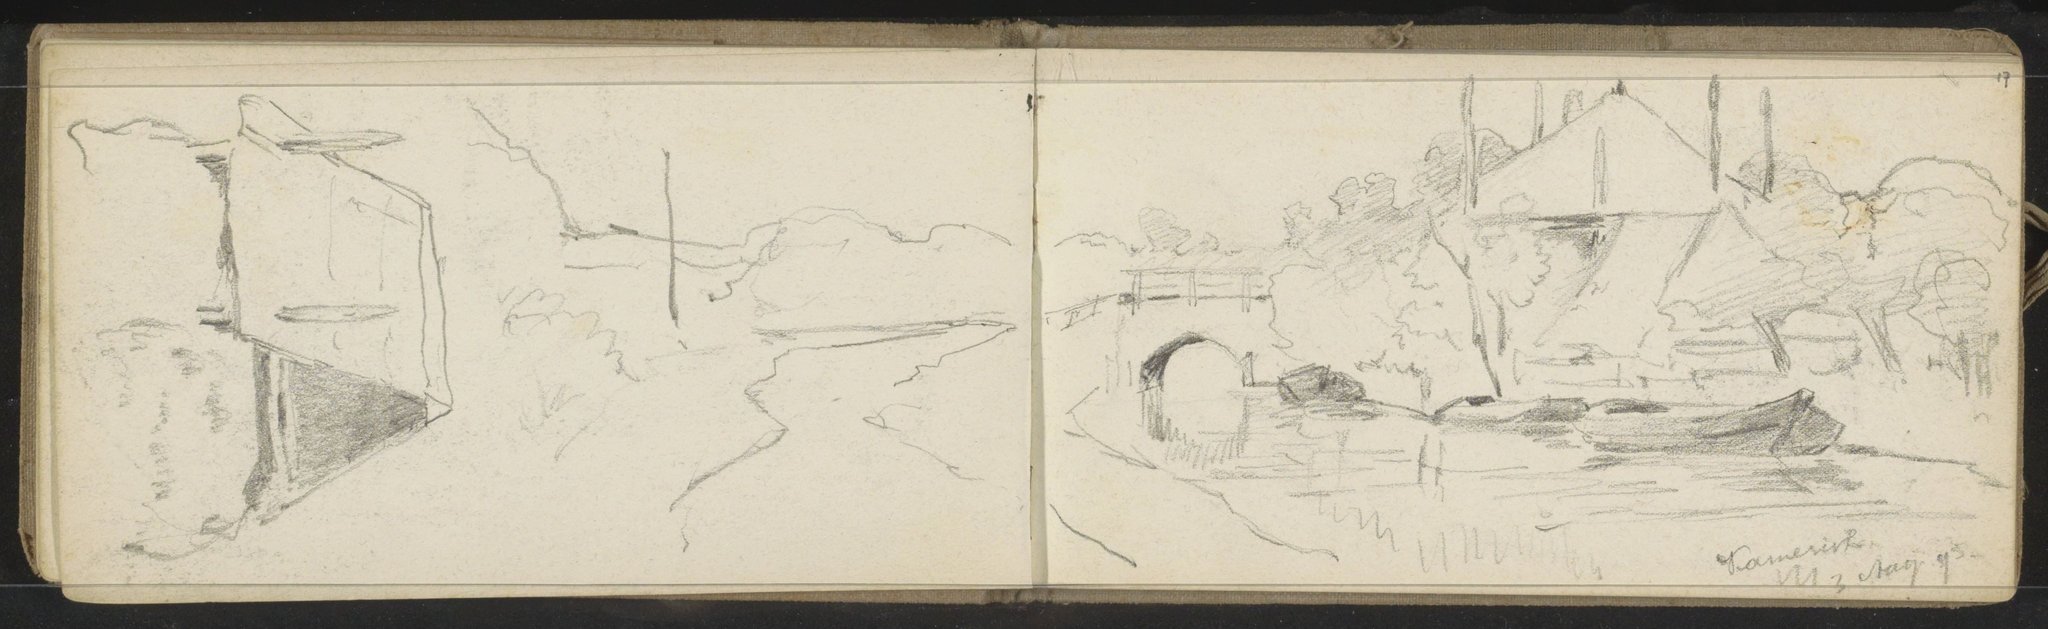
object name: sketchbook leaf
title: Landschap met water bij Kamerik en een hooiberg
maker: willem cornelis rip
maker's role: draughtsman, painter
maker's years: 1856-1922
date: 1808-1895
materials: paper, pencil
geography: kamerik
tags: landscapes with waters, waterscapes, seascapes (in the temperate zone), hay-stack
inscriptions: date and inscription: ‘Kamerik/ 3 Aug 95’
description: Blad 16 verso en 17 recto uit een schetsboek met 39 bladen.